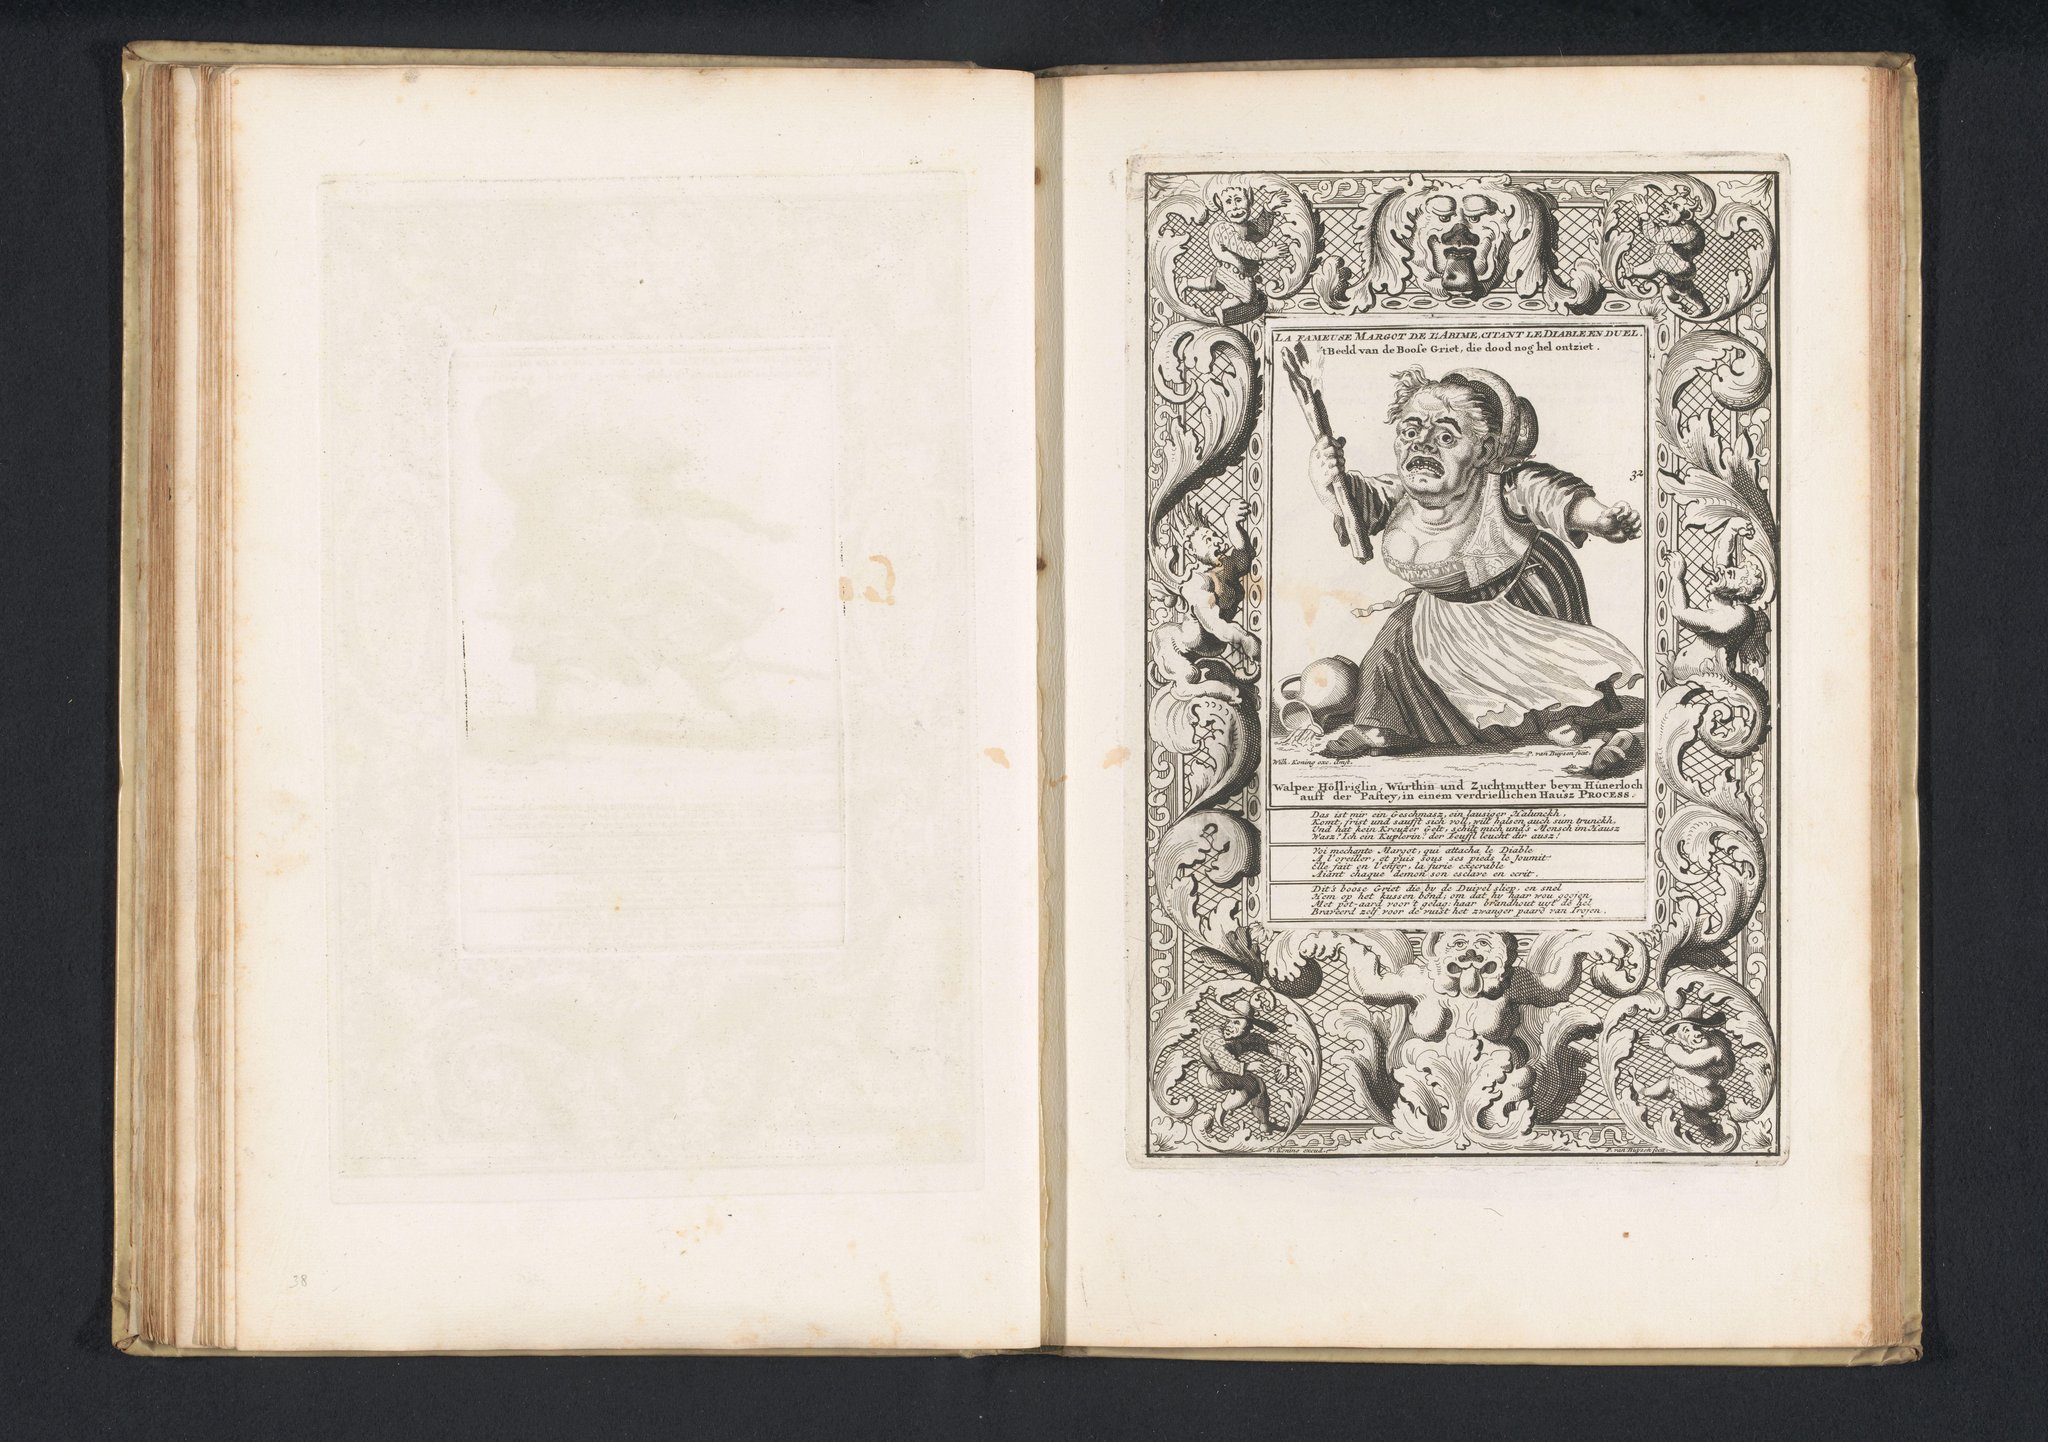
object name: print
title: Bombario Actionist en de Geest van Esopus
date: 1716-1720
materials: paper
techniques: etching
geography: amsterdam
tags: caricatures (human types), little people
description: De kleine mens Boose Griet als waardin met een brandend stuk hout. In het onderschrift verzen in het Duits, Frans en Nederlands. Genummerd rechts midden: 32. Afdruk binnen een decoratieve omlijsting gedrukt van een aparte plaat met monsters en harlekijnen. Onderdeel van deel II in de tweede Nederlandse gebonden uitgave uit 1720 (en gerelateerd aan de Windhandel in dat jaar) van een serie karikaturen van kleine mensen, bekend als Het Dwergentooneel, deels gekopieerd naar een ouder Duits voorbeeld.